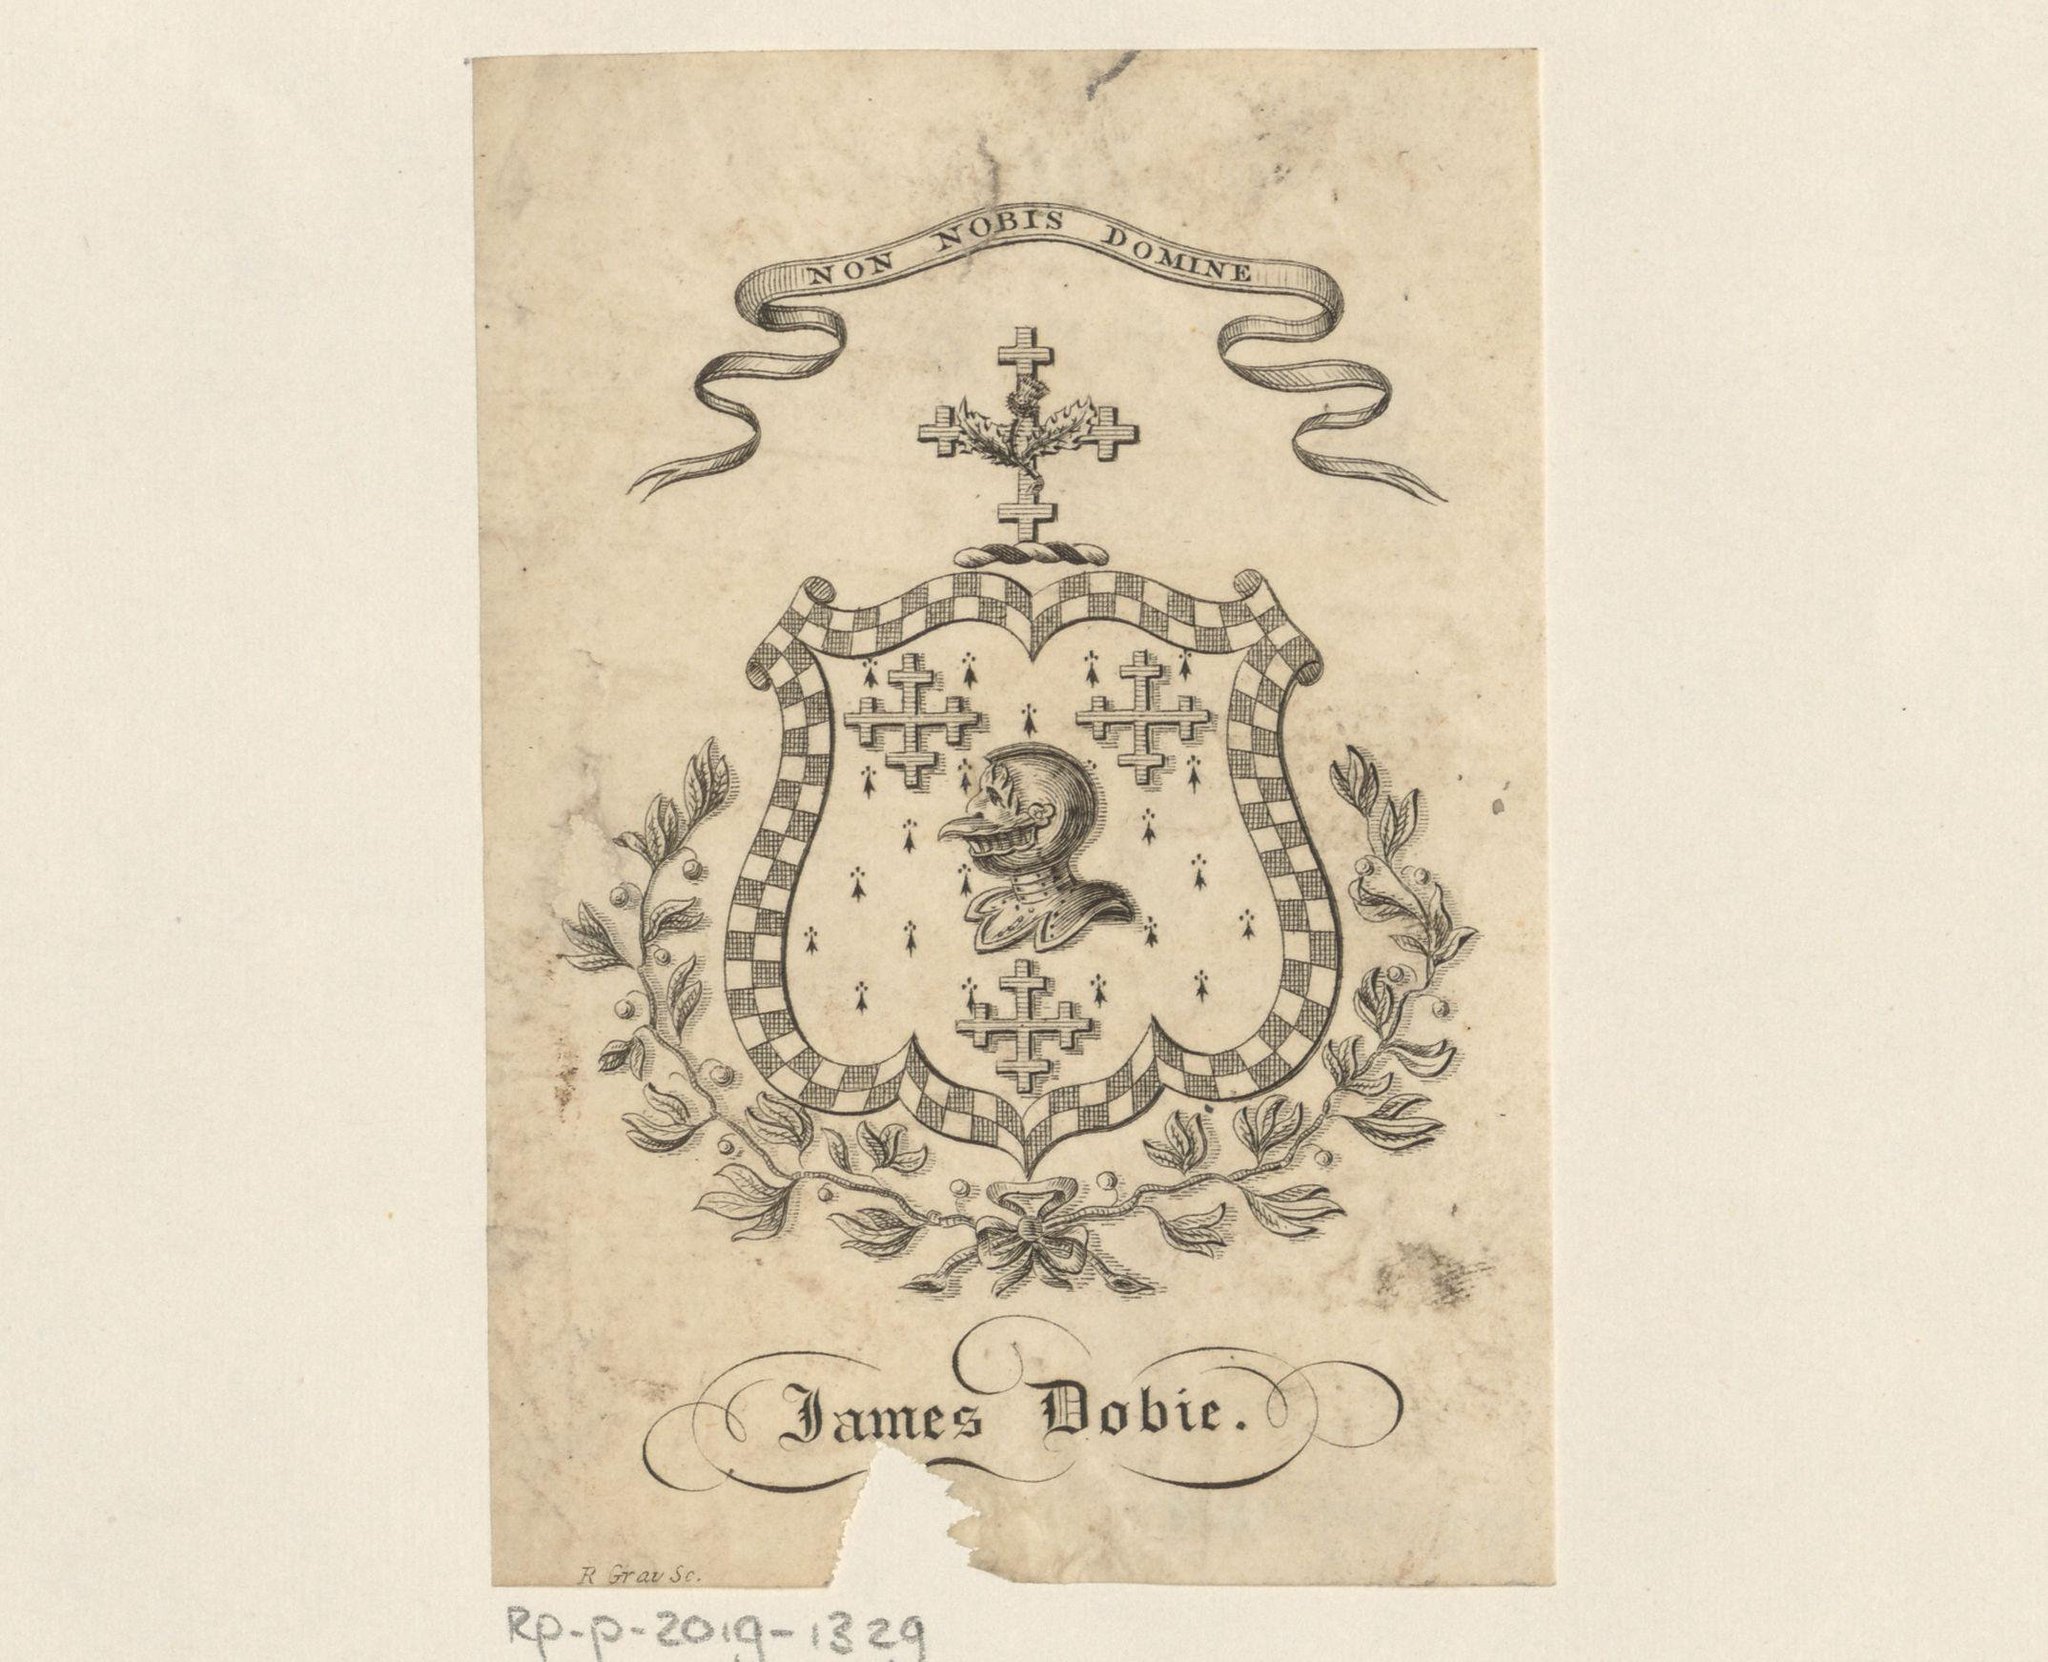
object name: bookplate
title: Ex libris van James Dobie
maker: r. gray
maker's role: print maker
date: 1830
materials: paper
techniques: engraving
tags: james dobie (schrijver), armorial bearing, heraldry